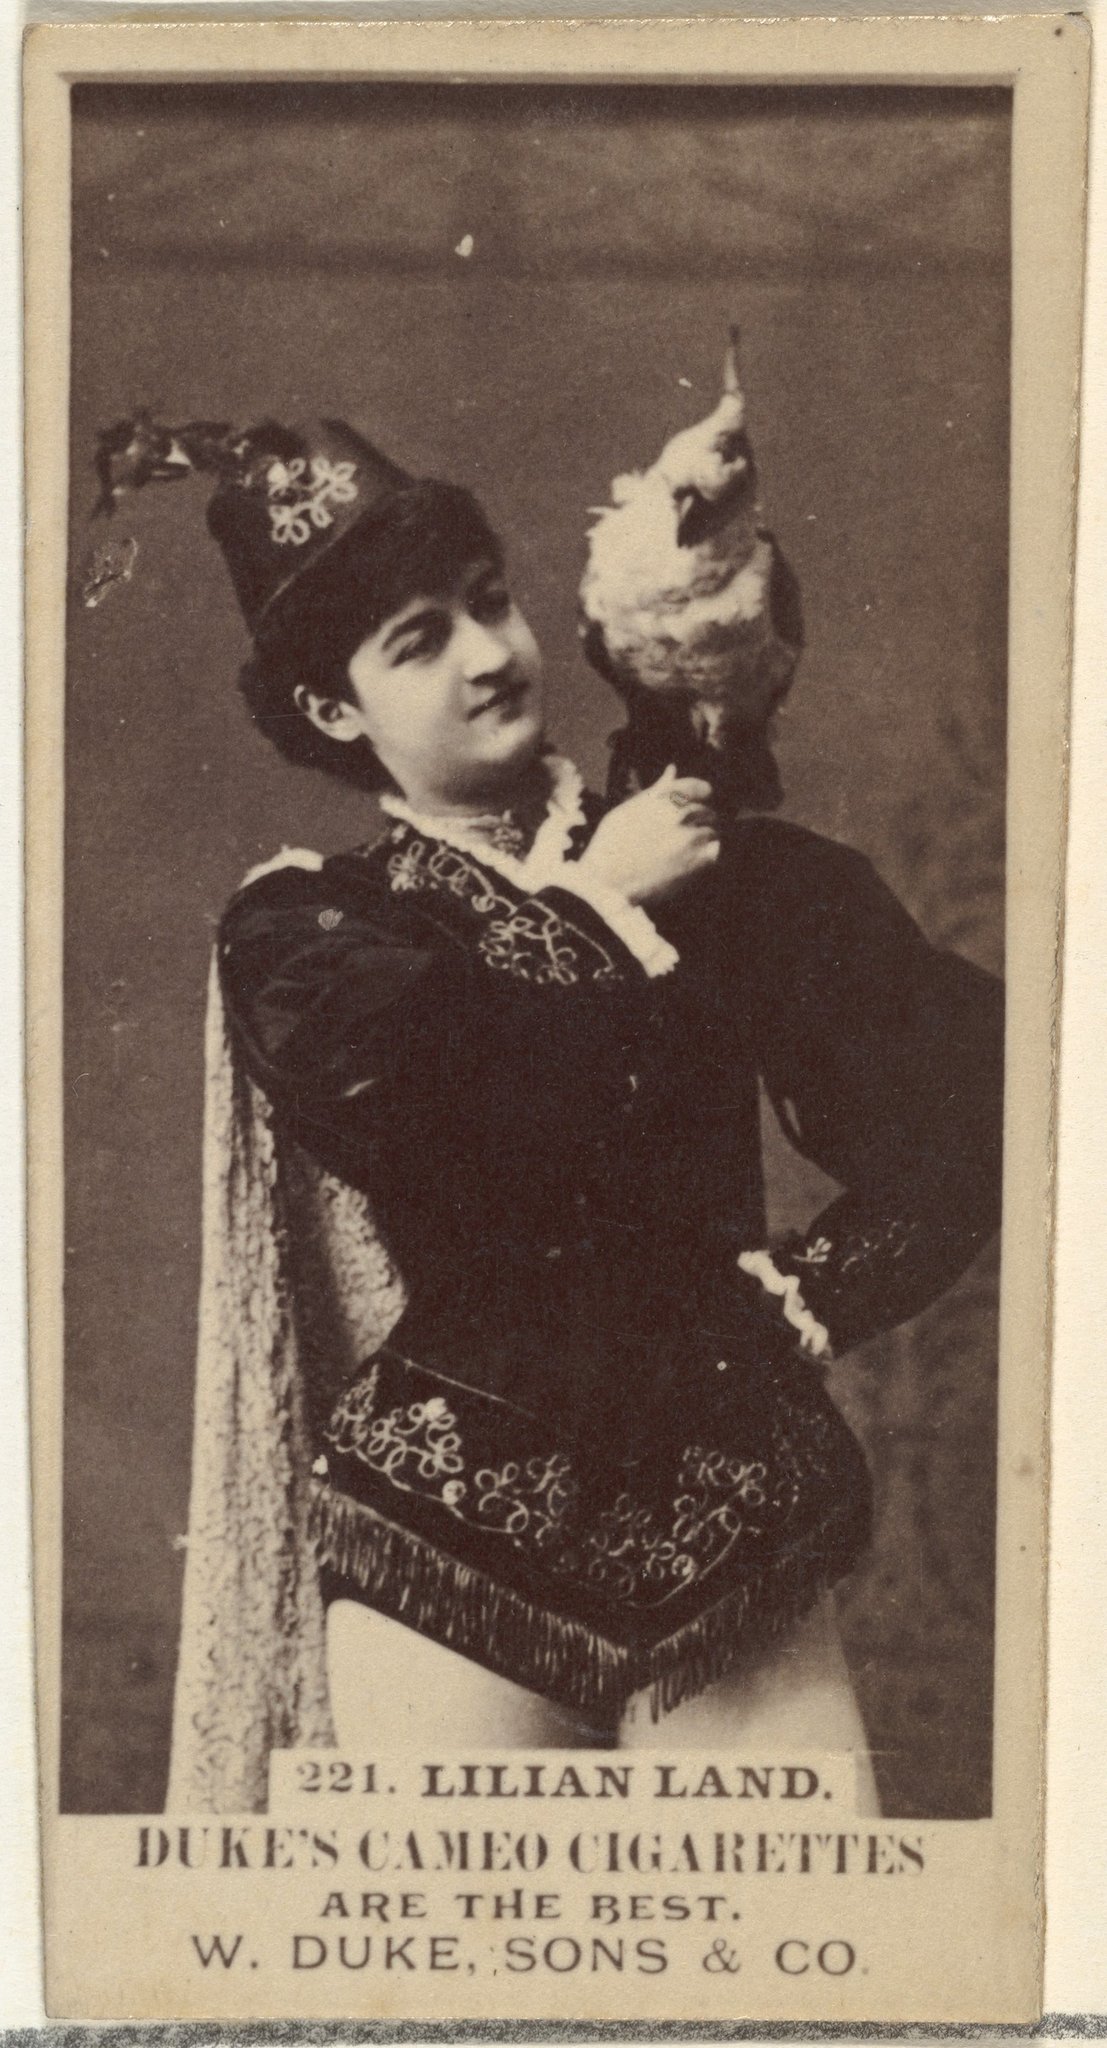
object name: photograph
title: Card Number 221, Lilian Land, from the Actors and Actresses series (N145-5) issued by Duke Sons & Co. to promote Cameo Cigarettes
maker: w. duke, sons & co.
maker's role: publisher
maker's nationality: american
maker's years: 1870-1920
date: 1880-1889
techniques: albumen silver print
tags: portraits,women,actresses